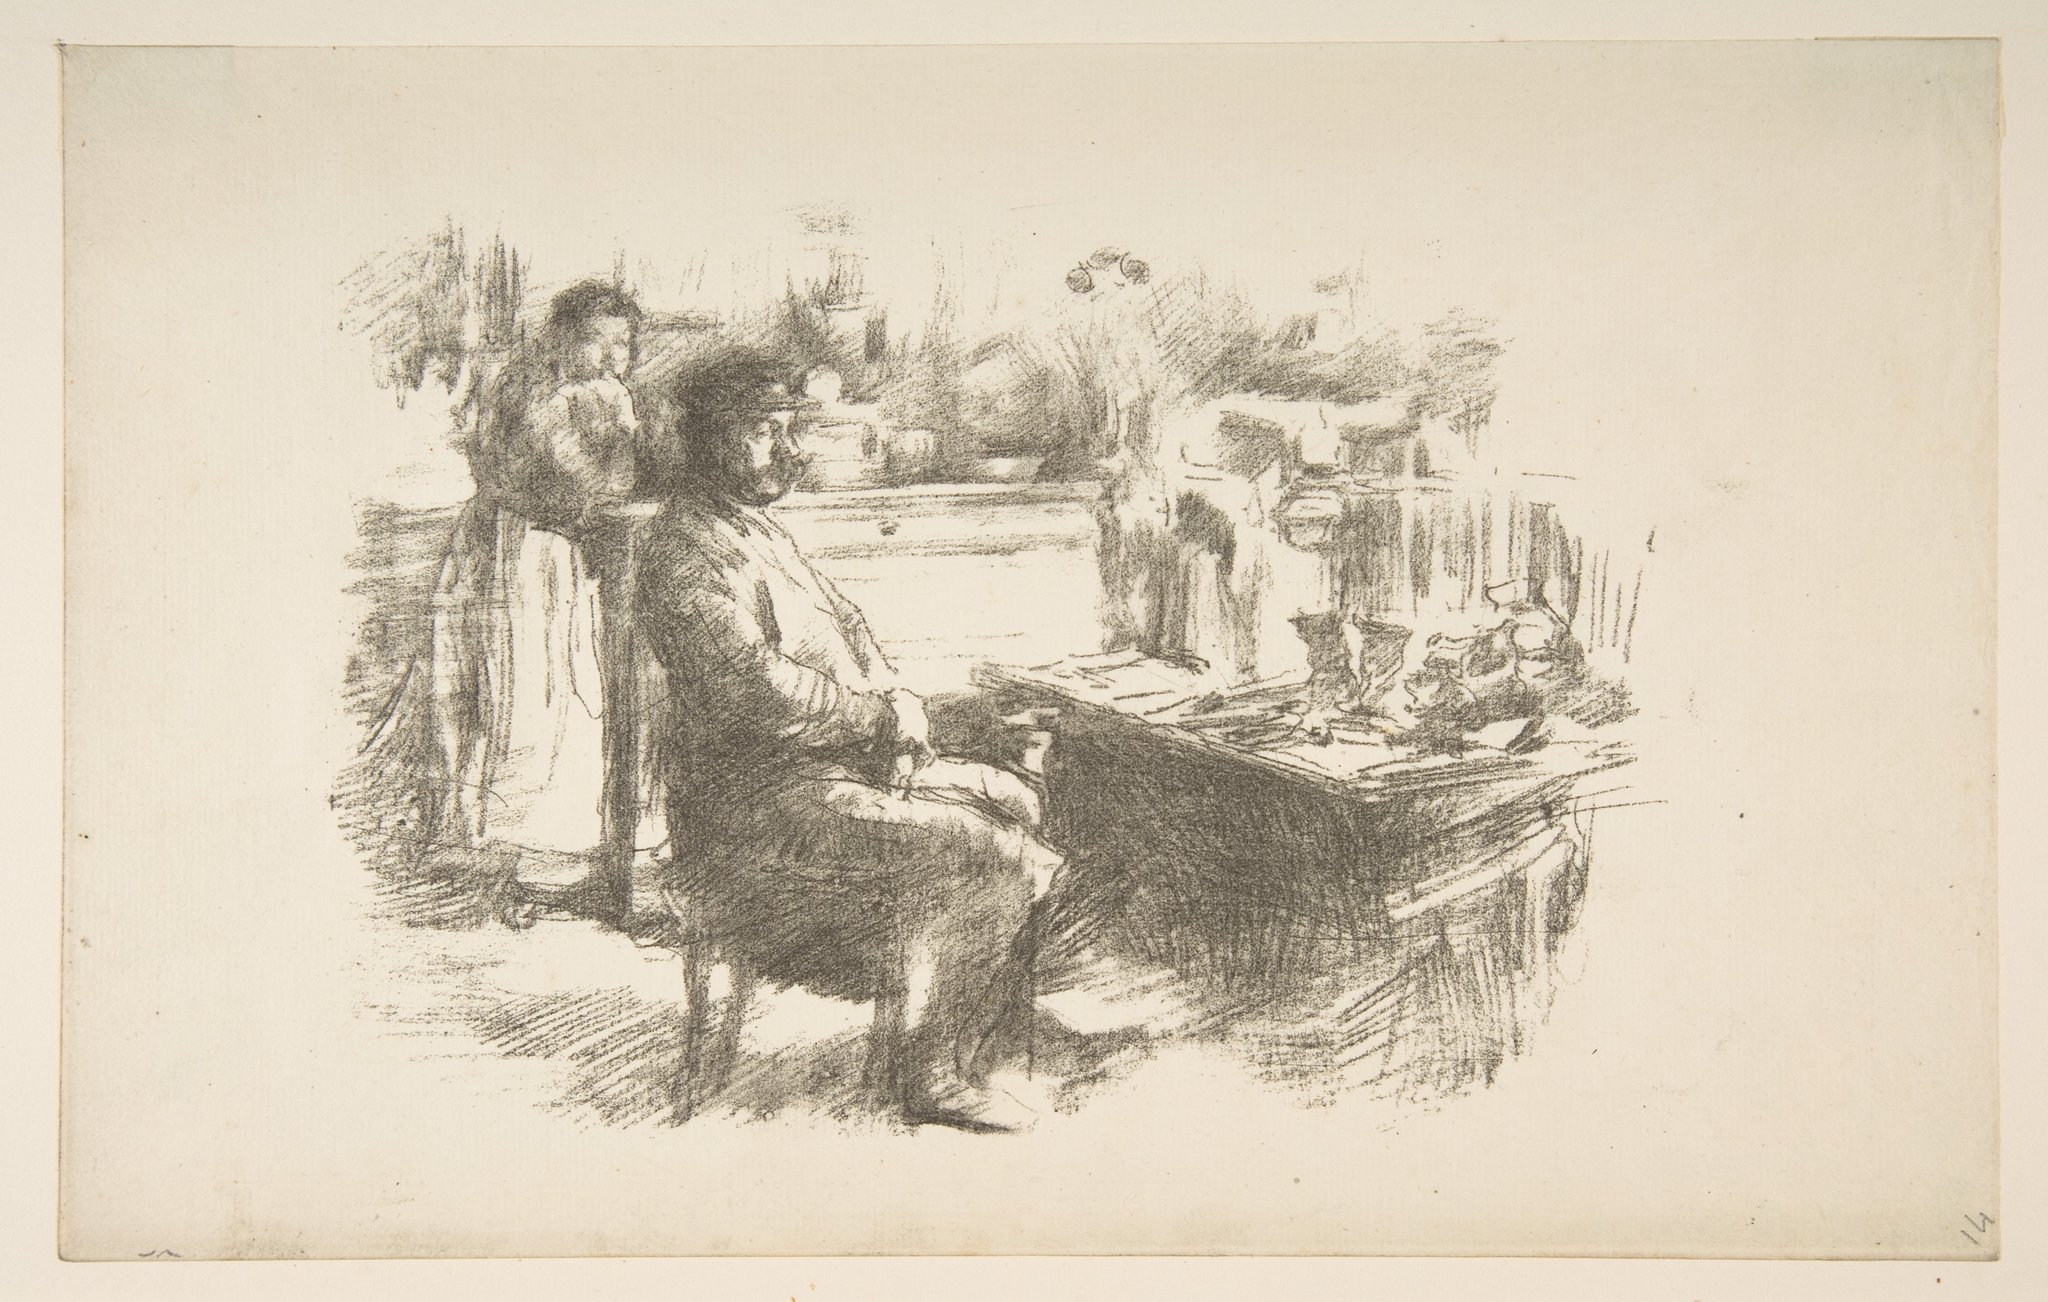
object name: print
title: The Shoemaker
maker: james mcneill whistler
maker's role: artist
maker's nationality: american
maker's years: 1834-1903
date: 1896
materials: ink, paper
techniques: printing, stumping, lithography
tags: men,women